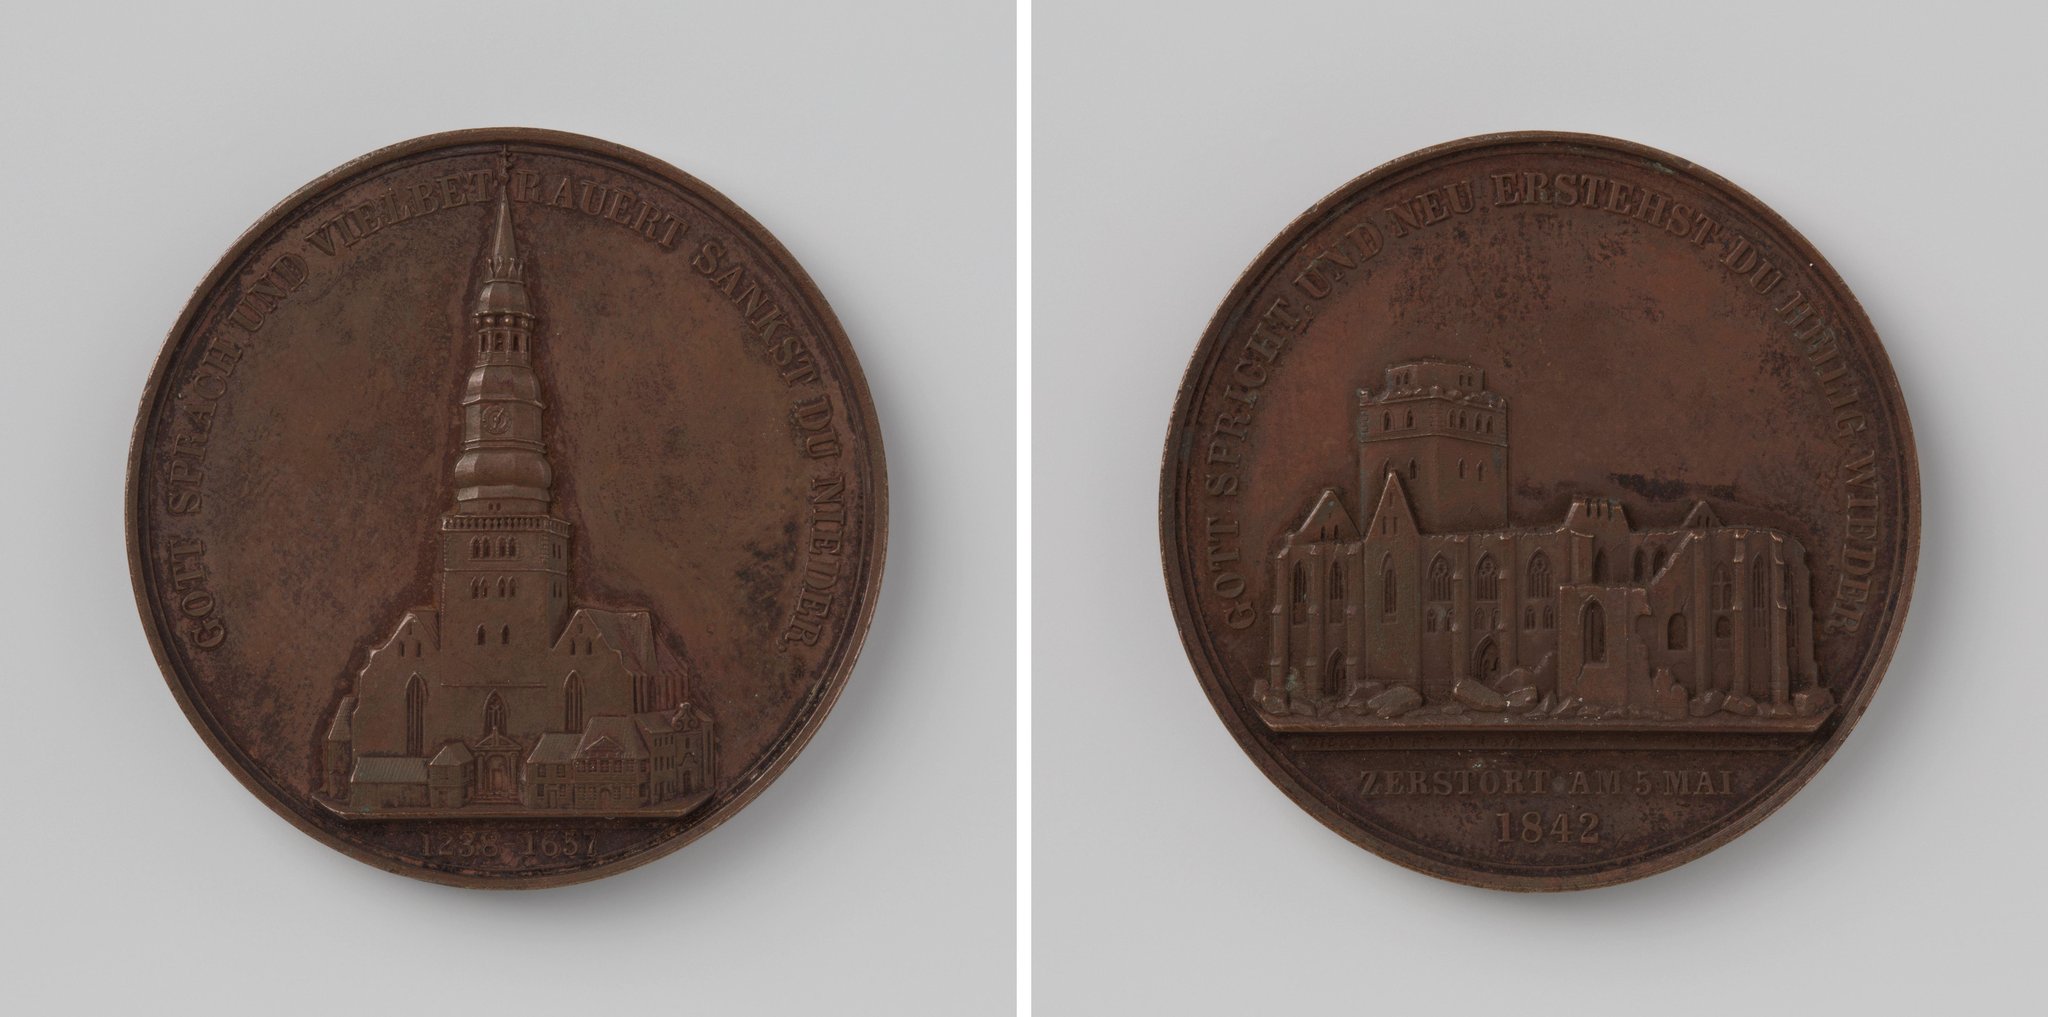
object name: history medal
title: Brand van de Nicolaikerk te Hamburg, penning geslagen uit het koper afkomstig van de kerktoren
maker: marten heinrich wilkens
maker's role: goldsmith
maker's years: 1782-1869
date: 1842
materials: copper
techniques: engraving, striking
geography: bremen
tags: sankt nikolaikirche (hamburg)